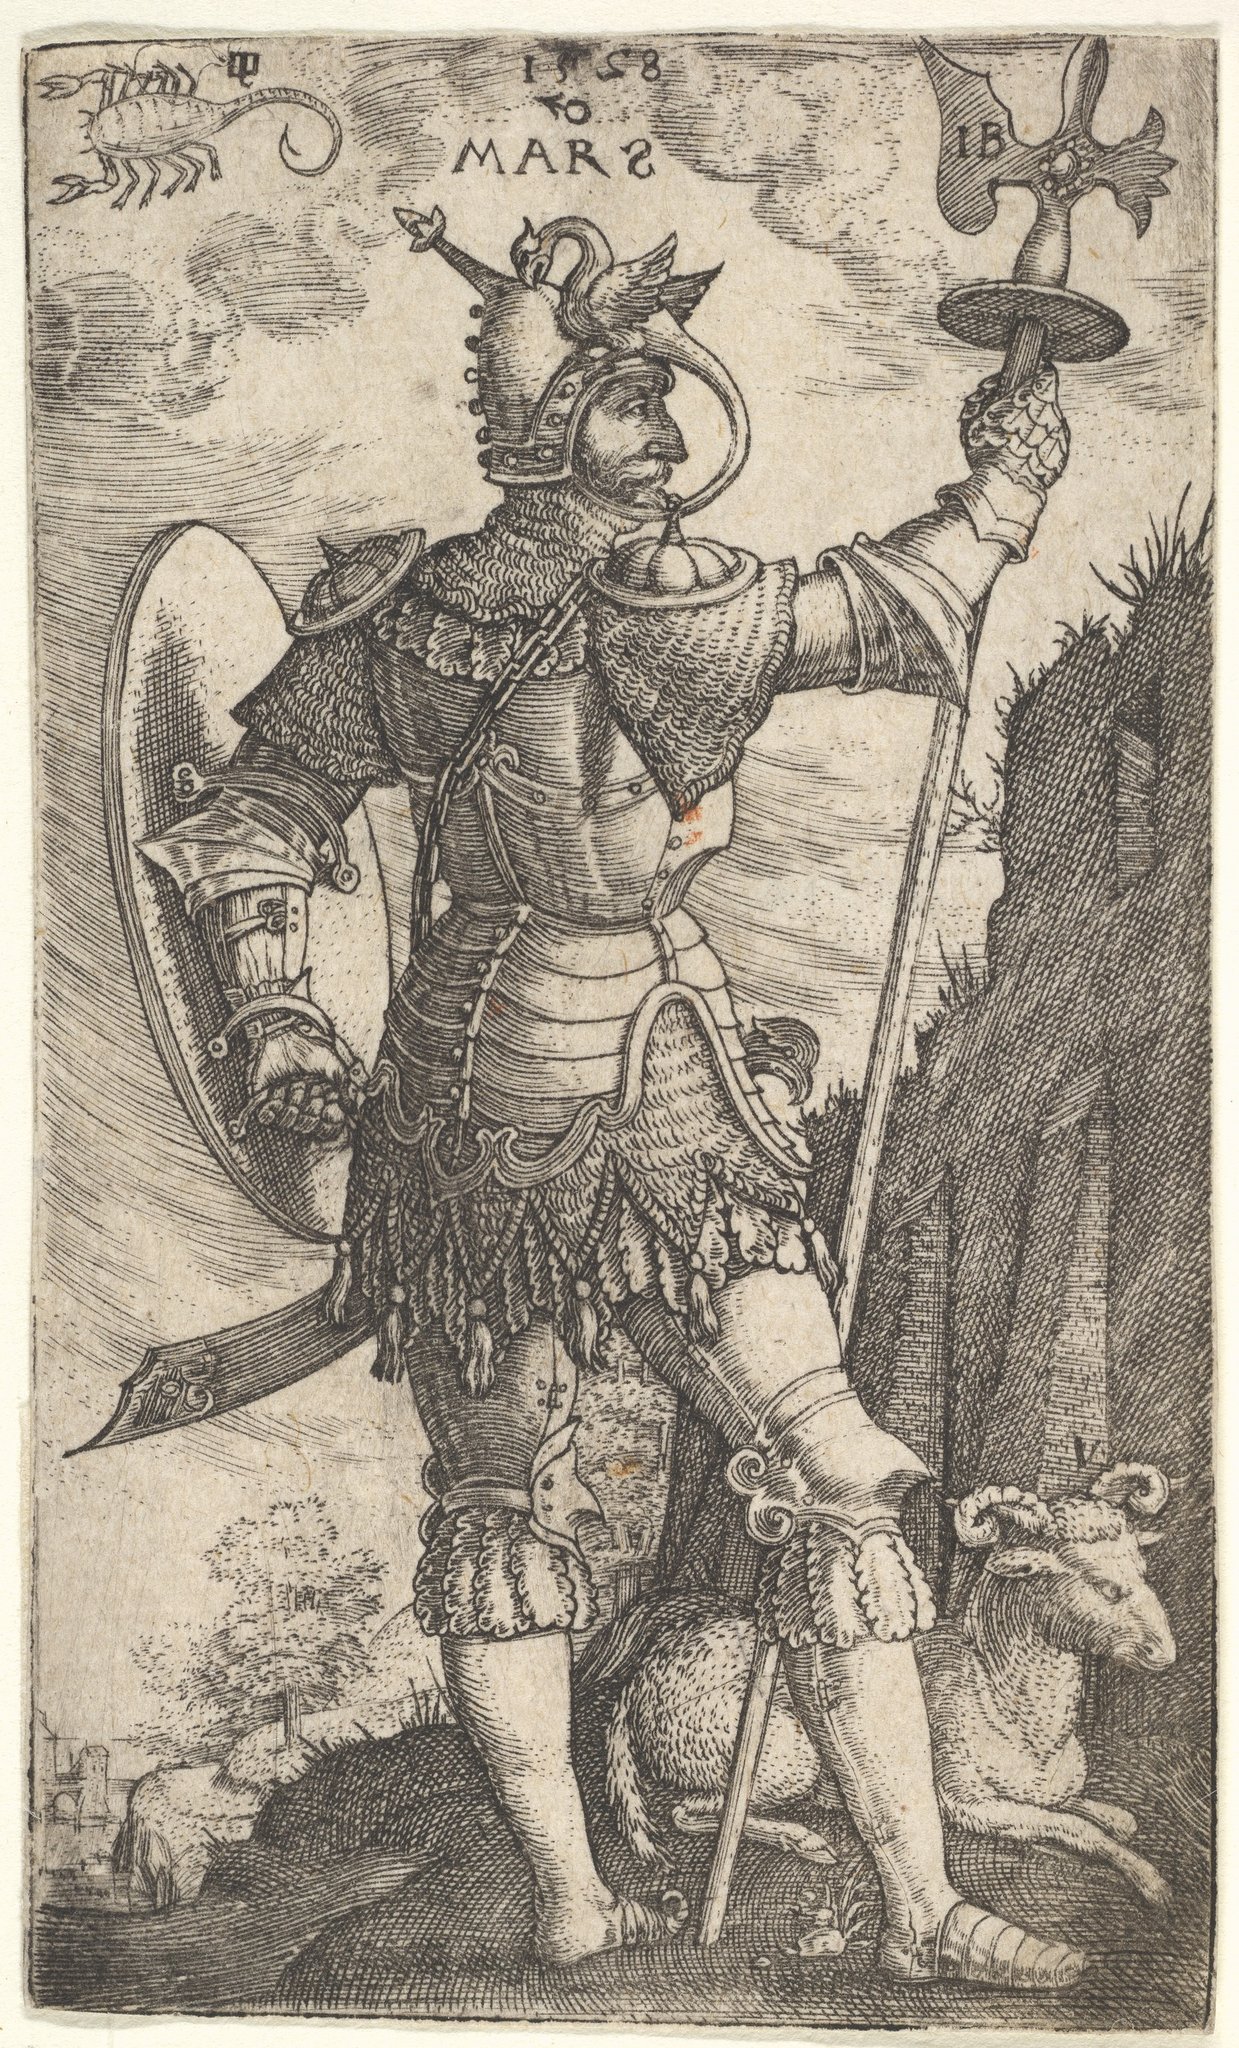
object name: print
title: Mars, from "The Gods Who Preside Over the Planets"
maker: master i.b.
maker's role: artist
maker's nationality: german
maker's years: 1525-1530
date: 1528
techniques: etching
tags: animals,armor,shields,weapons,mars,rams